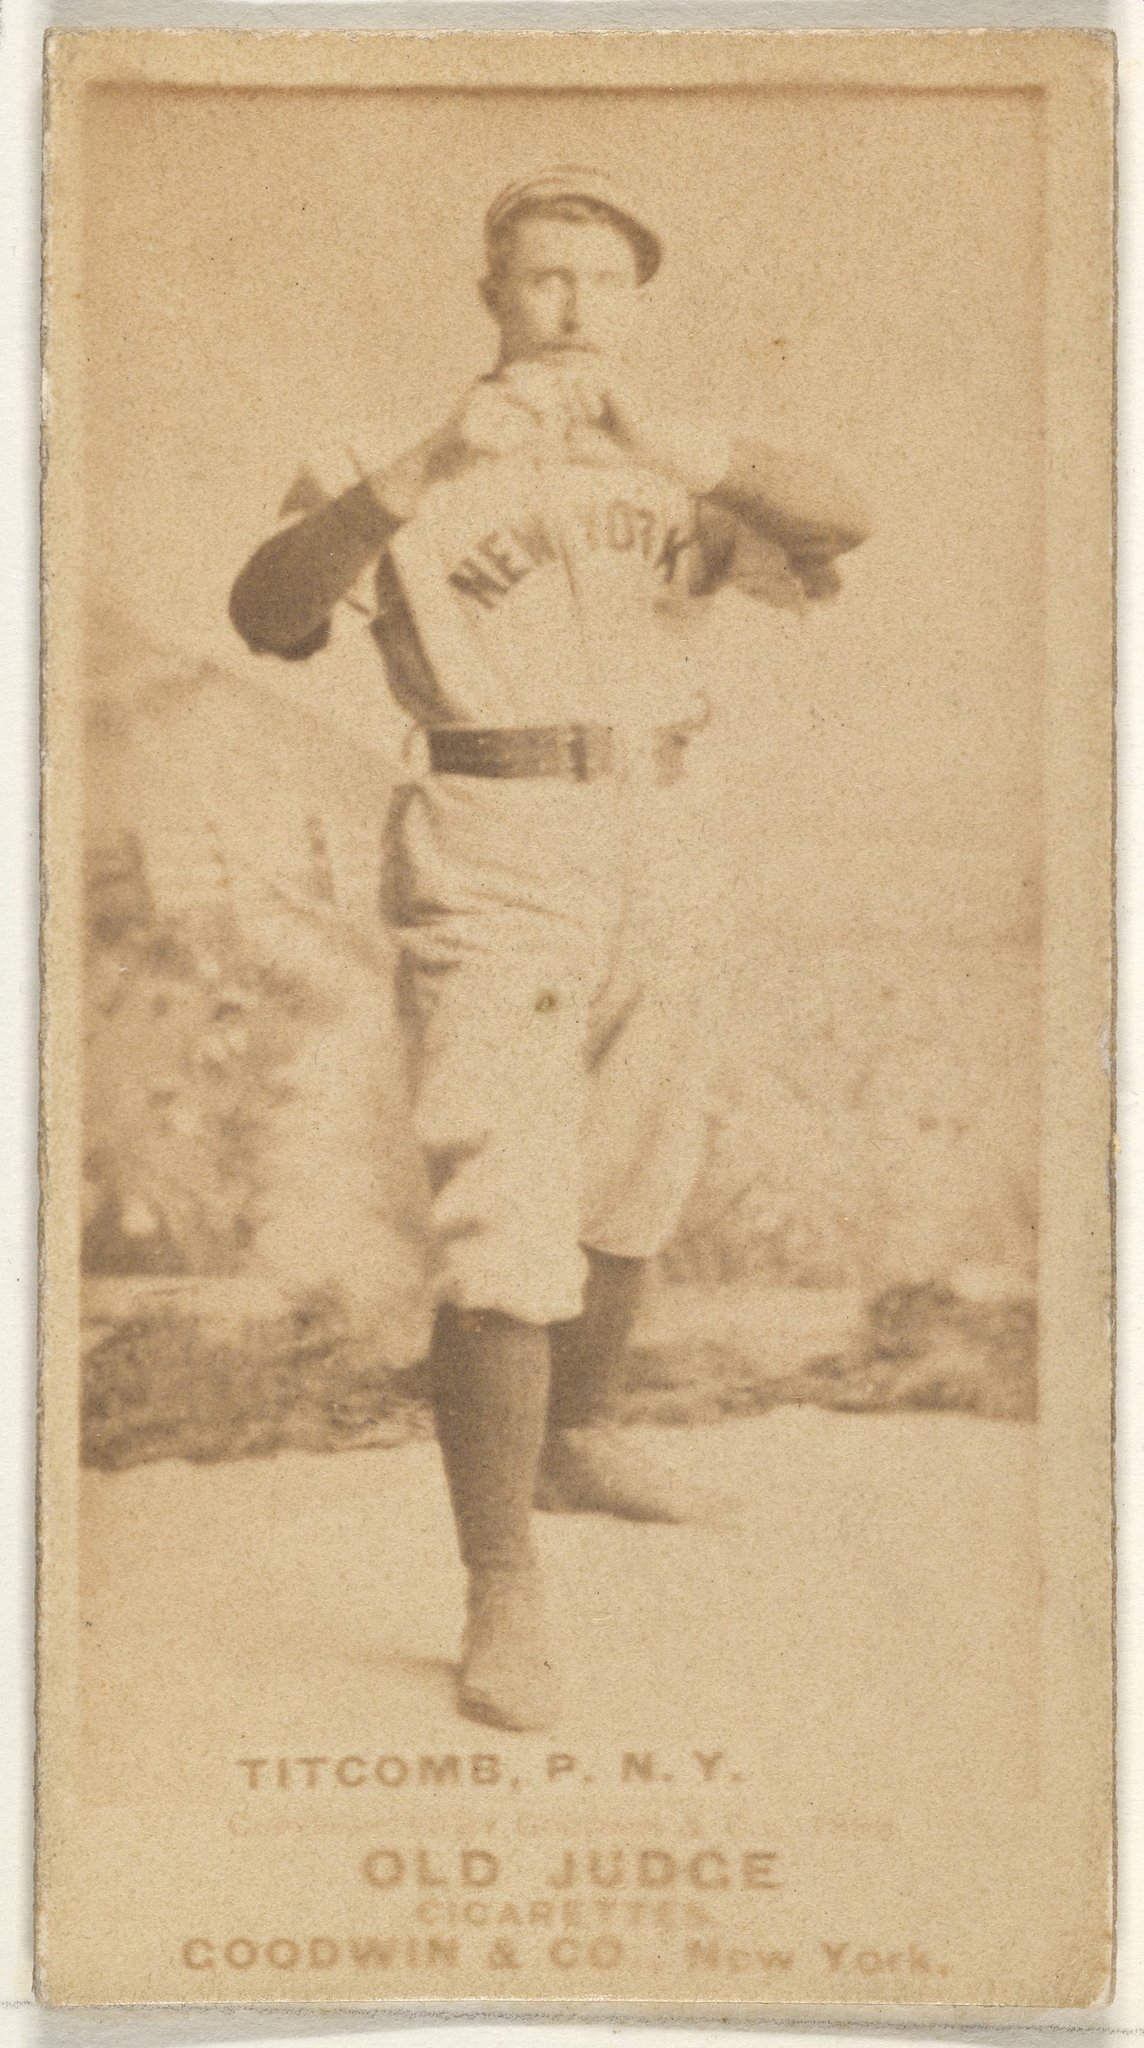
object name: baseball card, photograph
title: Ledell "Cannonball" Titcomb, Pitcher, New York, from the Old Judge series (N172) for Old Judge Cigarettes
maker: goodwin & company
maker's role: publisher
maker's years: 1850-1950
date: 1888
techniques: albumen silver print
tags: men,portraits,baseball,athletes